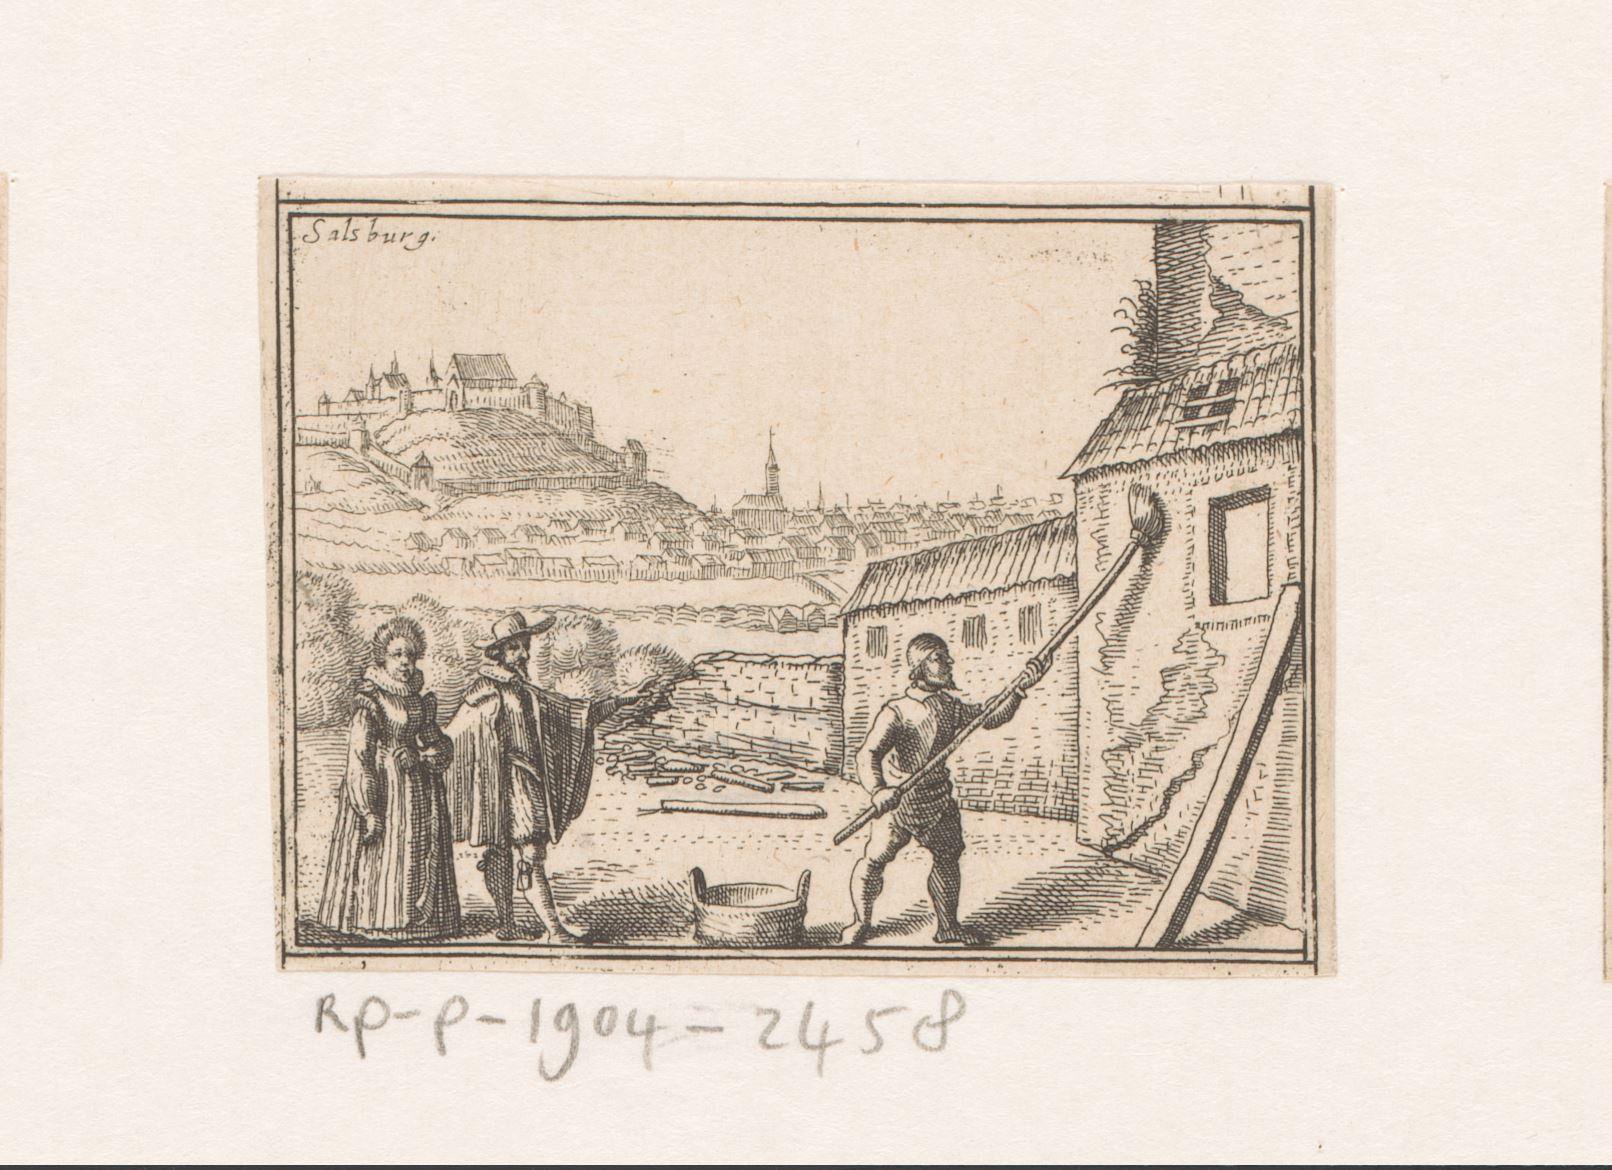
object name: book illustration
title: Gezicht op Salzburg met een bouwvakker op de voorgrond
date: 1624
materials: paper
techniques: etching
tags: building activities, city-view, and landscape with man-made constructions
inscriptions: collector's mark: Lugt 2228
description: Prent uit: Sudermann, Daniel. Centuria Similitudinum, Hubert Gleichnussen. Straatsburg, Jacob van der Heyden, 1624. (Hollstein German XXVIA 646).